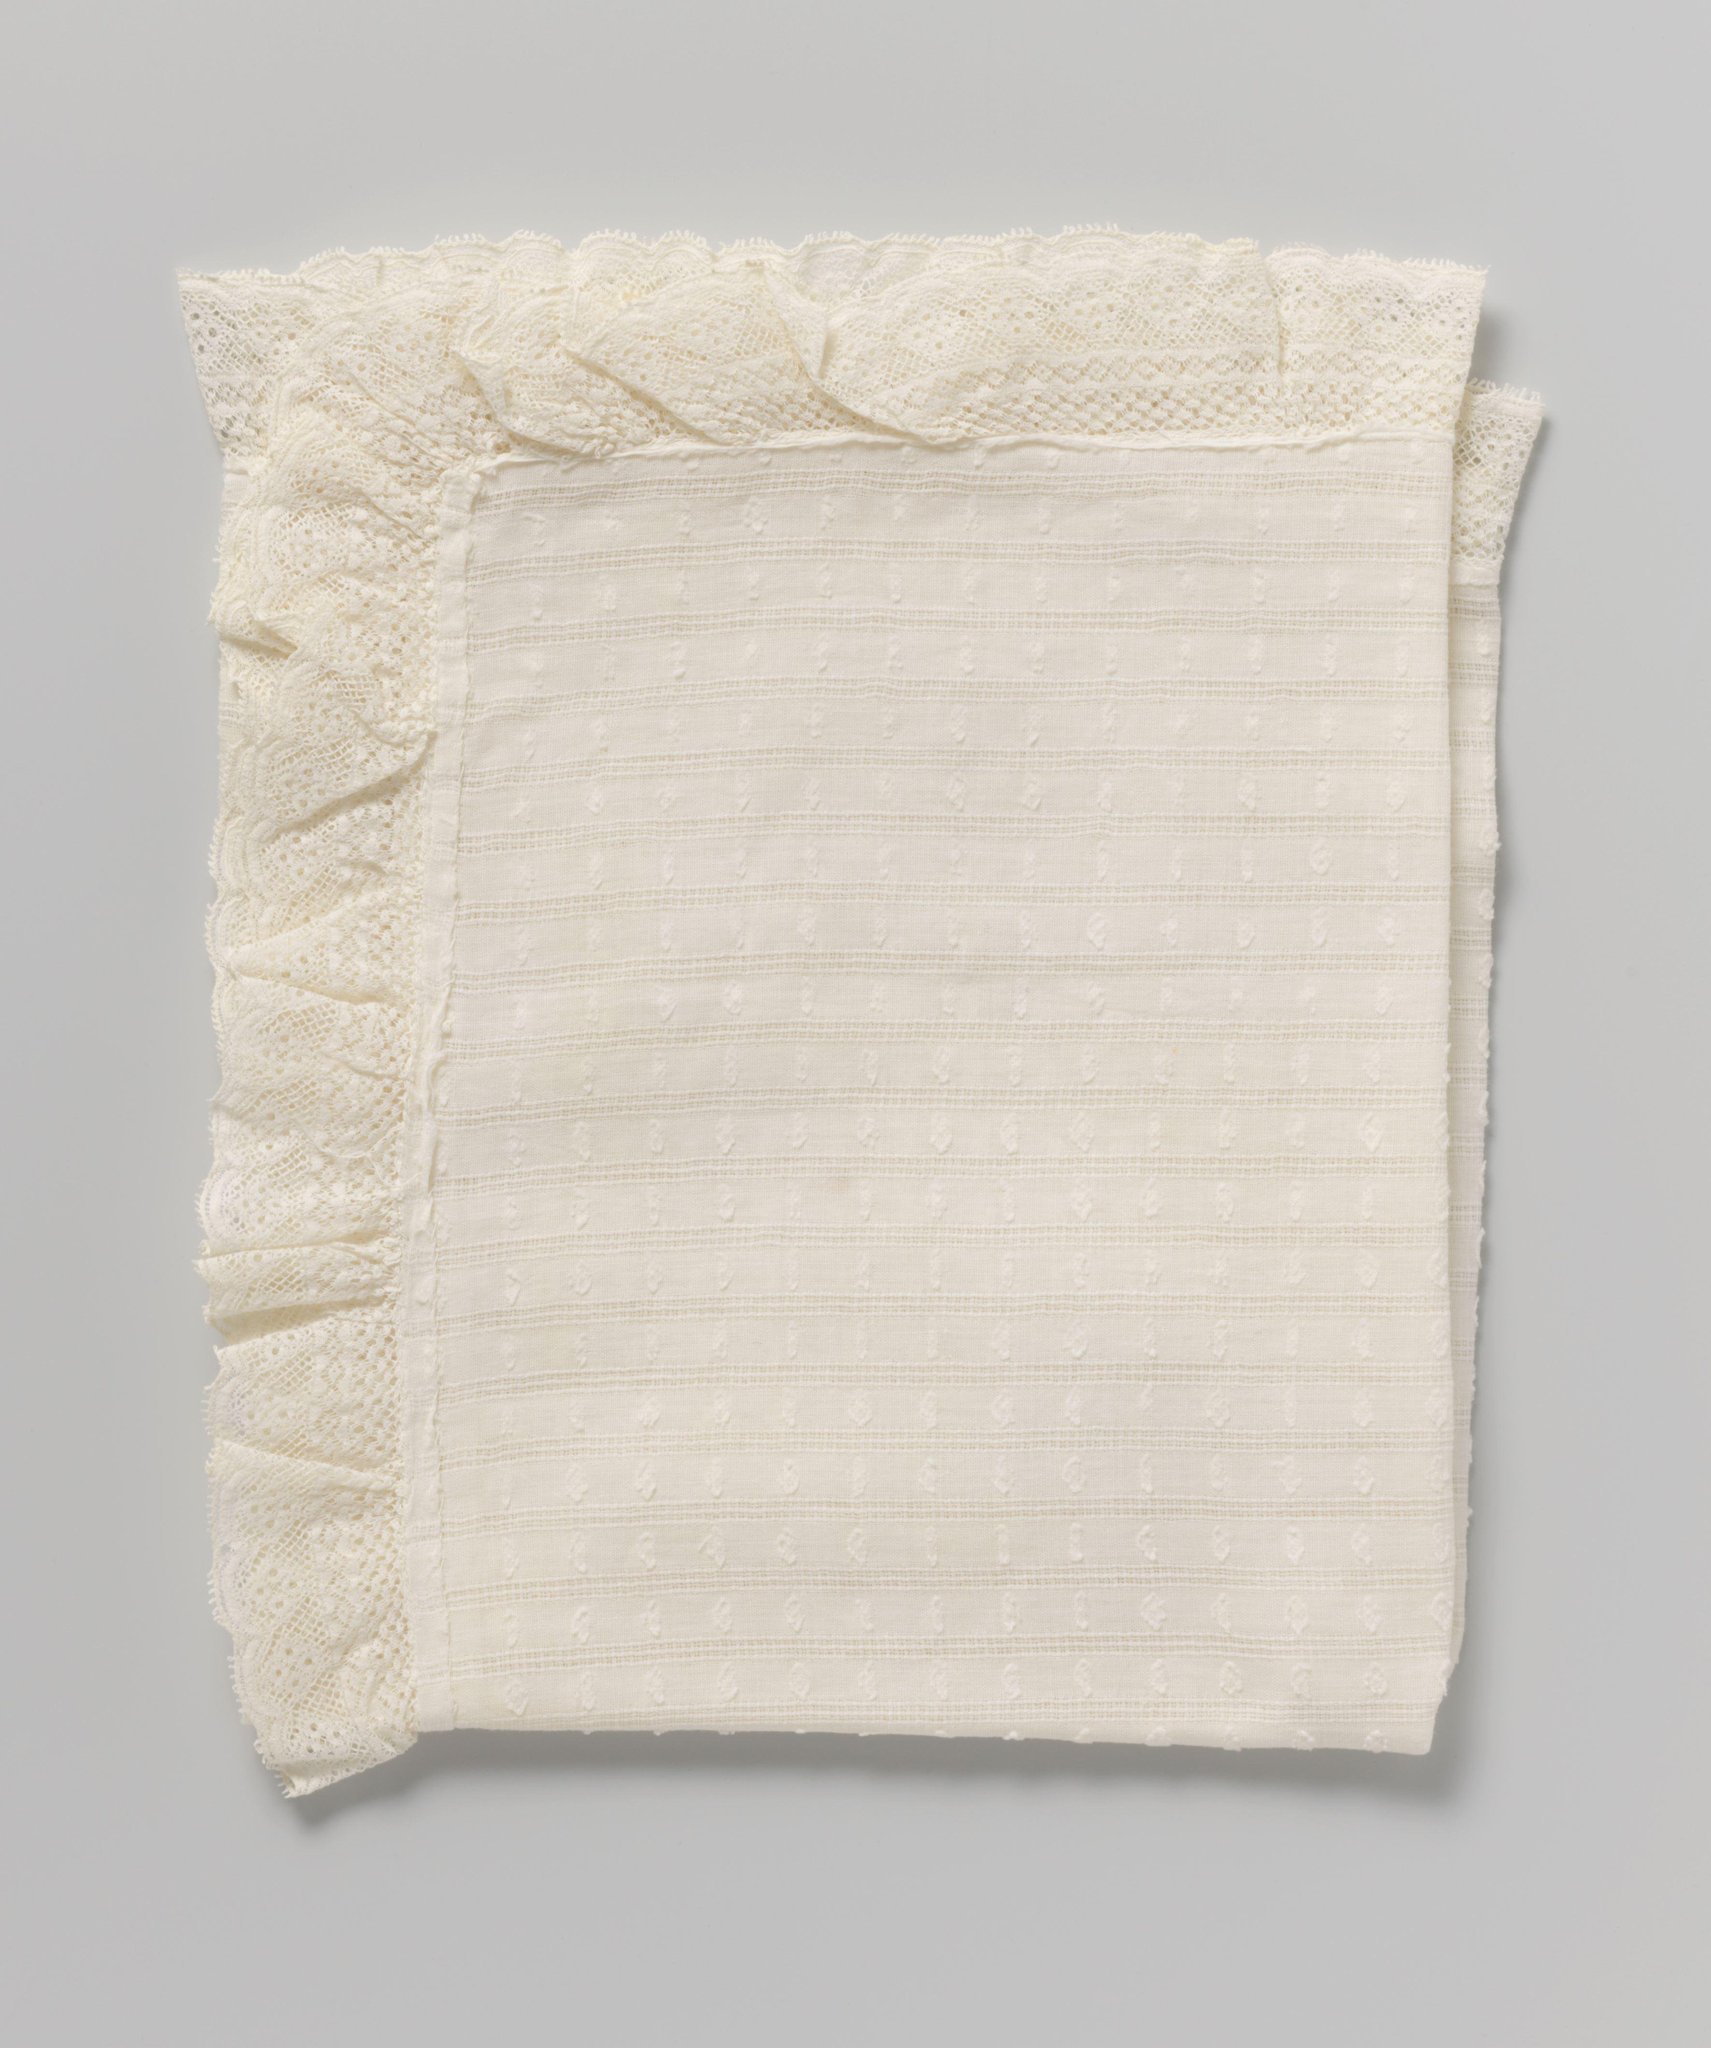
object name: dekkleed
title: Dekkleed voor wieg of luiermand van genopt en ajour geweven neteldoek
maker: Anonymous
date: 1900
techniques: embroidery, weave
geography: netherlands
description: Dekkleed voor wieg of luiermand van genopt en ajour geweven neteldoek. Model: rechthoekig, rondom afgezet met machinale kant met driedelig patroon: van binnenuit een lijst met spinnenfond, een bies met dubbele slingerlijn en een geschulpte strook met rozetten op vierkante mazen. Nederland, ca. 1900. Toestand: een slijtscheur. Luiermandgoed.